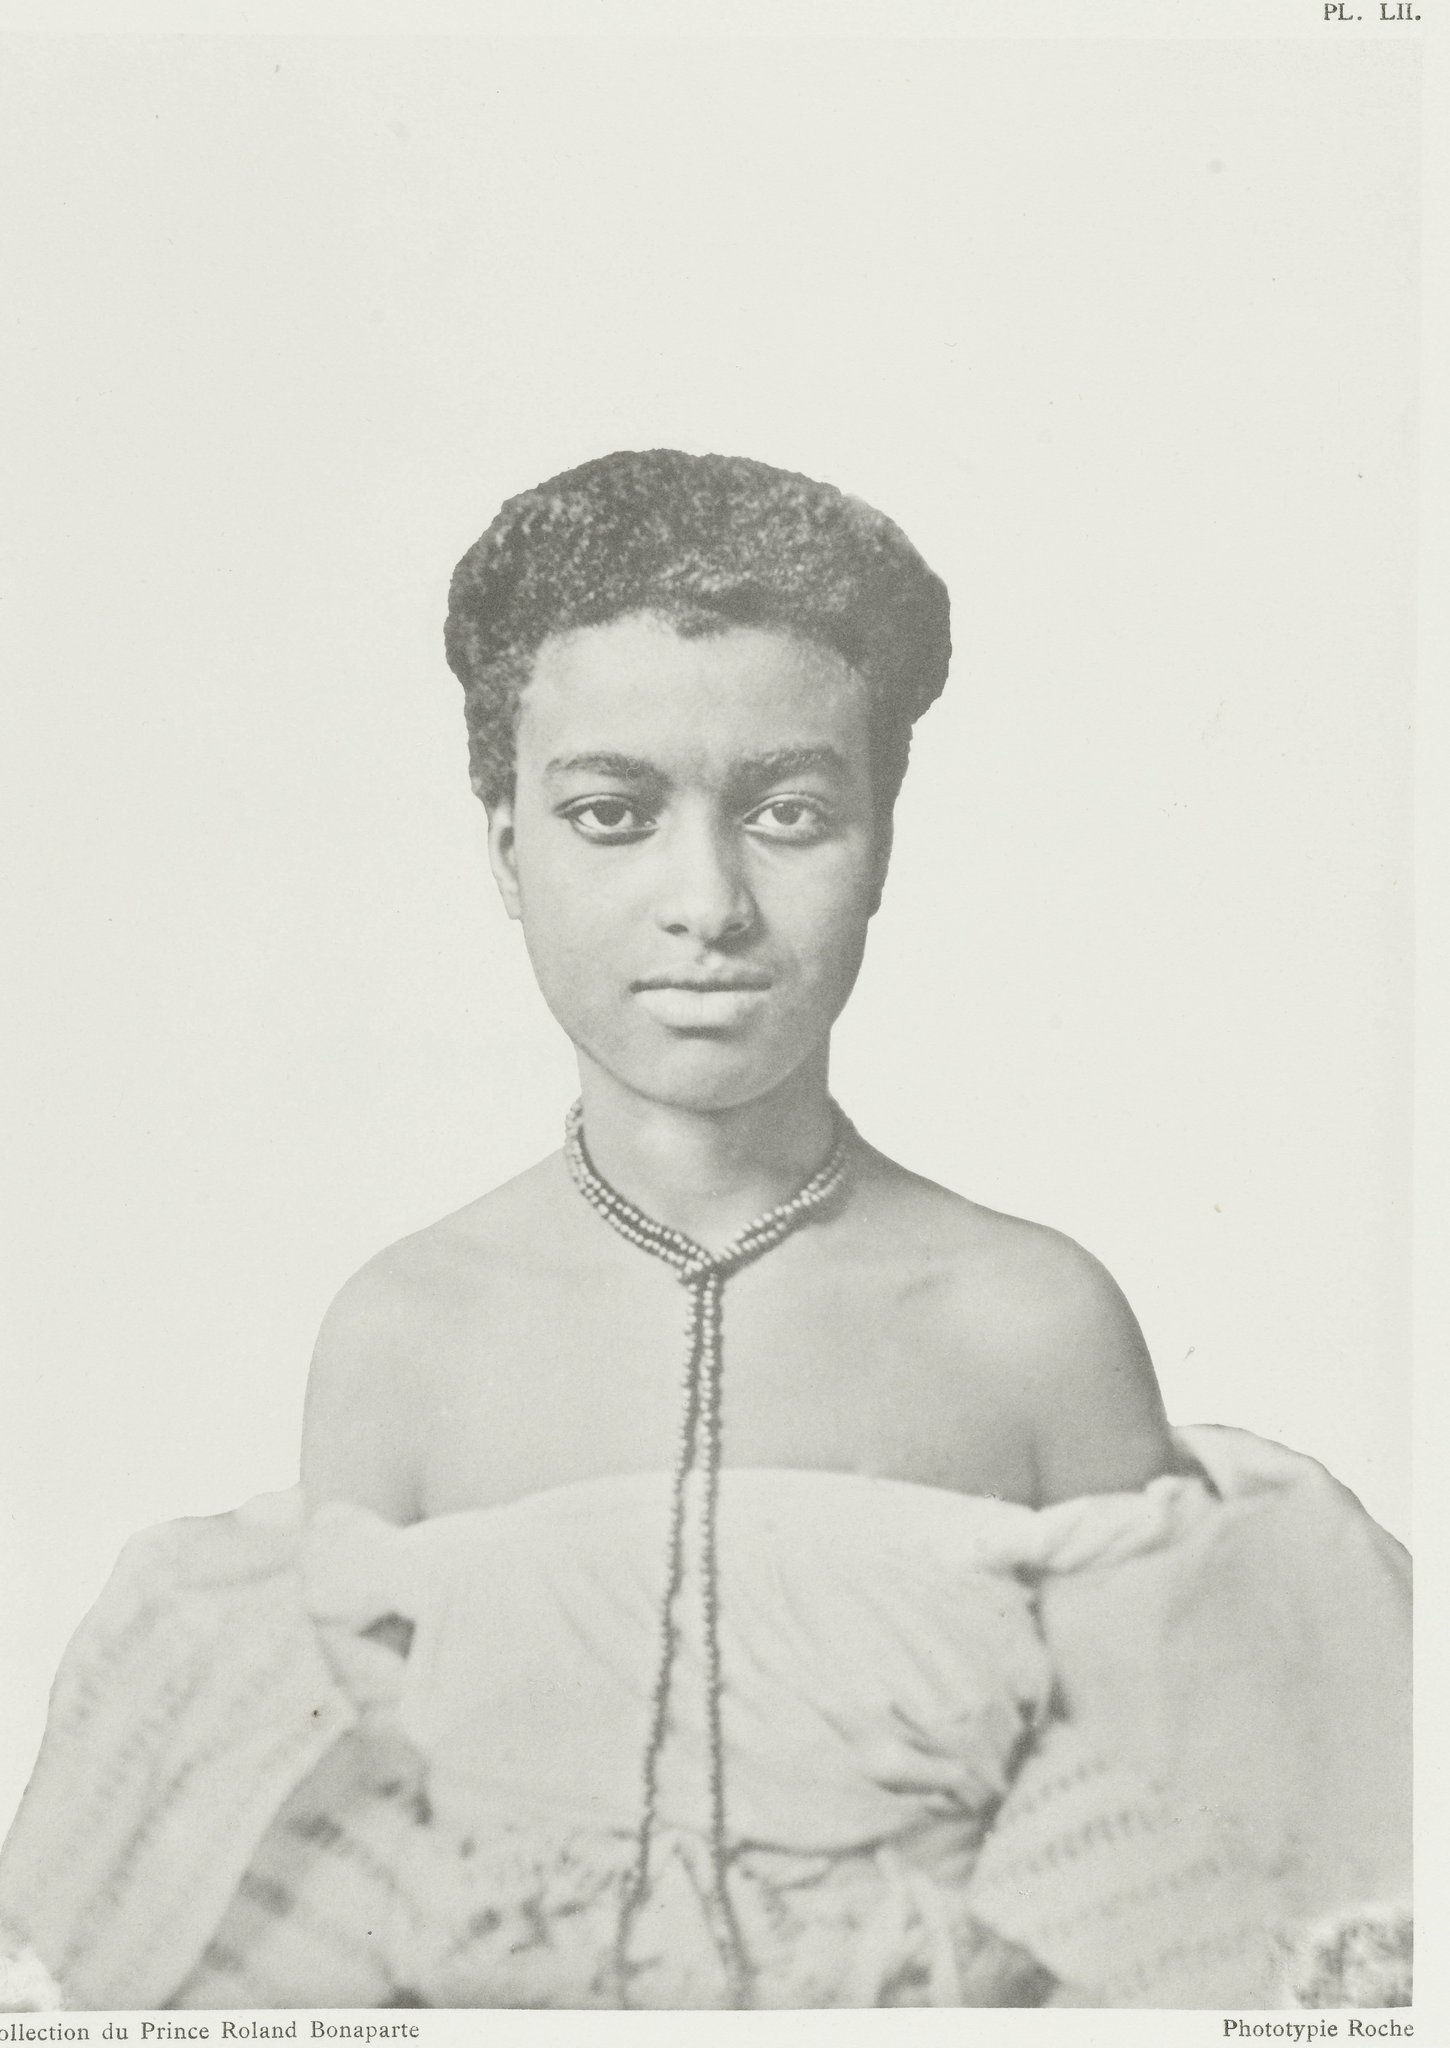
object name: page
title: Portret van Gerardina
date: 1883-1884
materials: paper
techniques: photograph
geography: amsterdam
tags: adolescent, young woman, maiden, historical persons, amsterdam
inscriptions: inscription: ‘Collection du Prince Roland Bonaparte/ Phototypie Roche’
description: Portret van Gerardina, een Surinaamse vrouw van Afrikaanse en Europese oorsprong, gefotografeerd op de Internationale Koloniale en Uitvoerhandel Tentoonstelling, Amsterdam 1883.